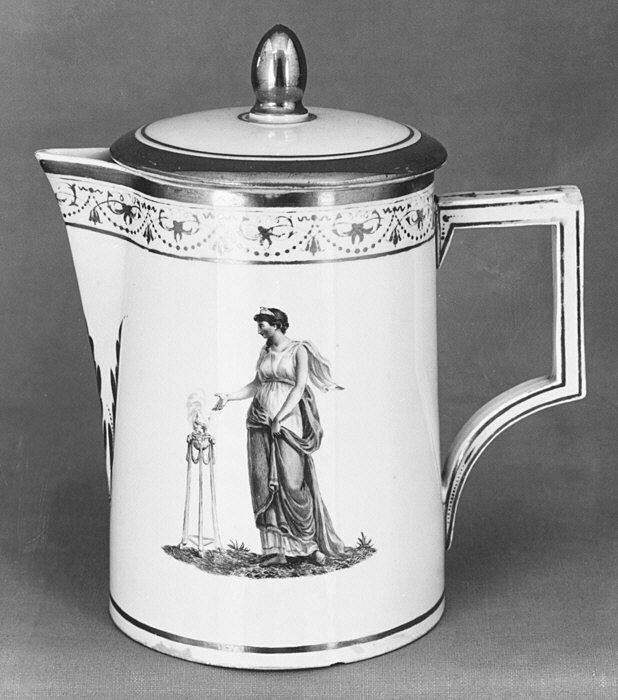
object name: milk pot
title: Milk pot (?) (part of a coffee service)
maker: nymphenburg porcelain manufactory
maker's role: manufactory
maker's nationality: german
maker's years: 1747-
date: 1801-1833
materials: hard paste porcelain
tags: women